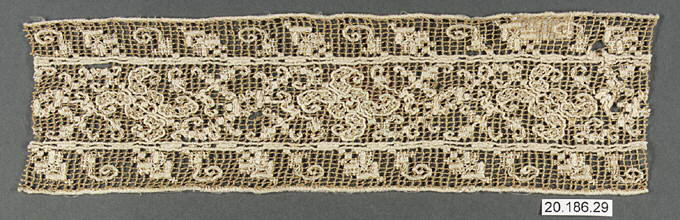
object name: strip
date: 1501-1600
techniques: embroidery